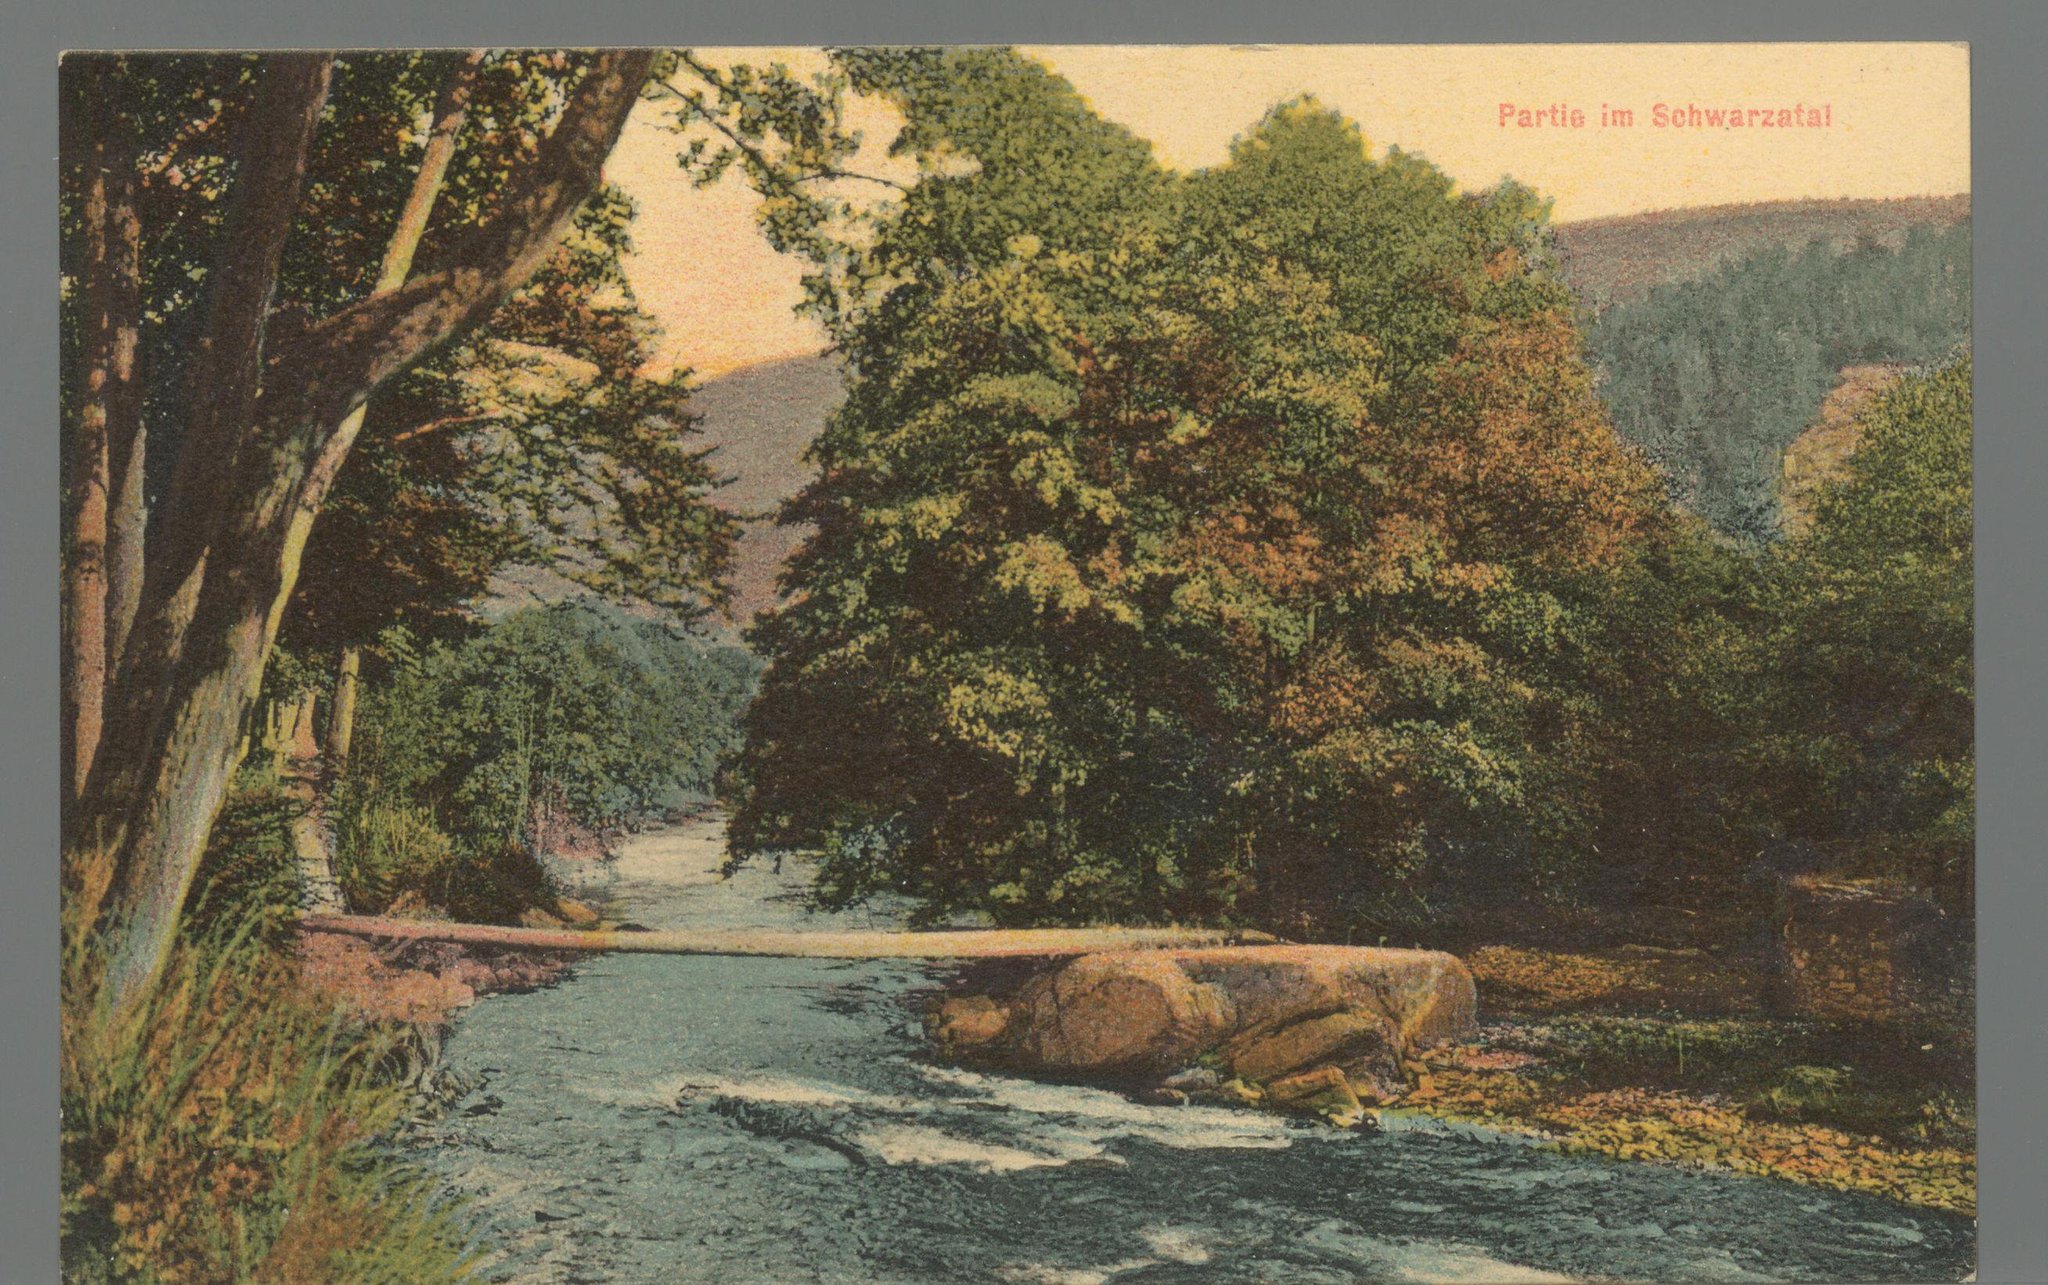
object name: photomechanical print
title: Partie im Schwarzatal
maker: Anonymous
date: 1905-1930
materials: cardboard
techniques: photograph, lithograph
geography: dresden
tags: river, mountains